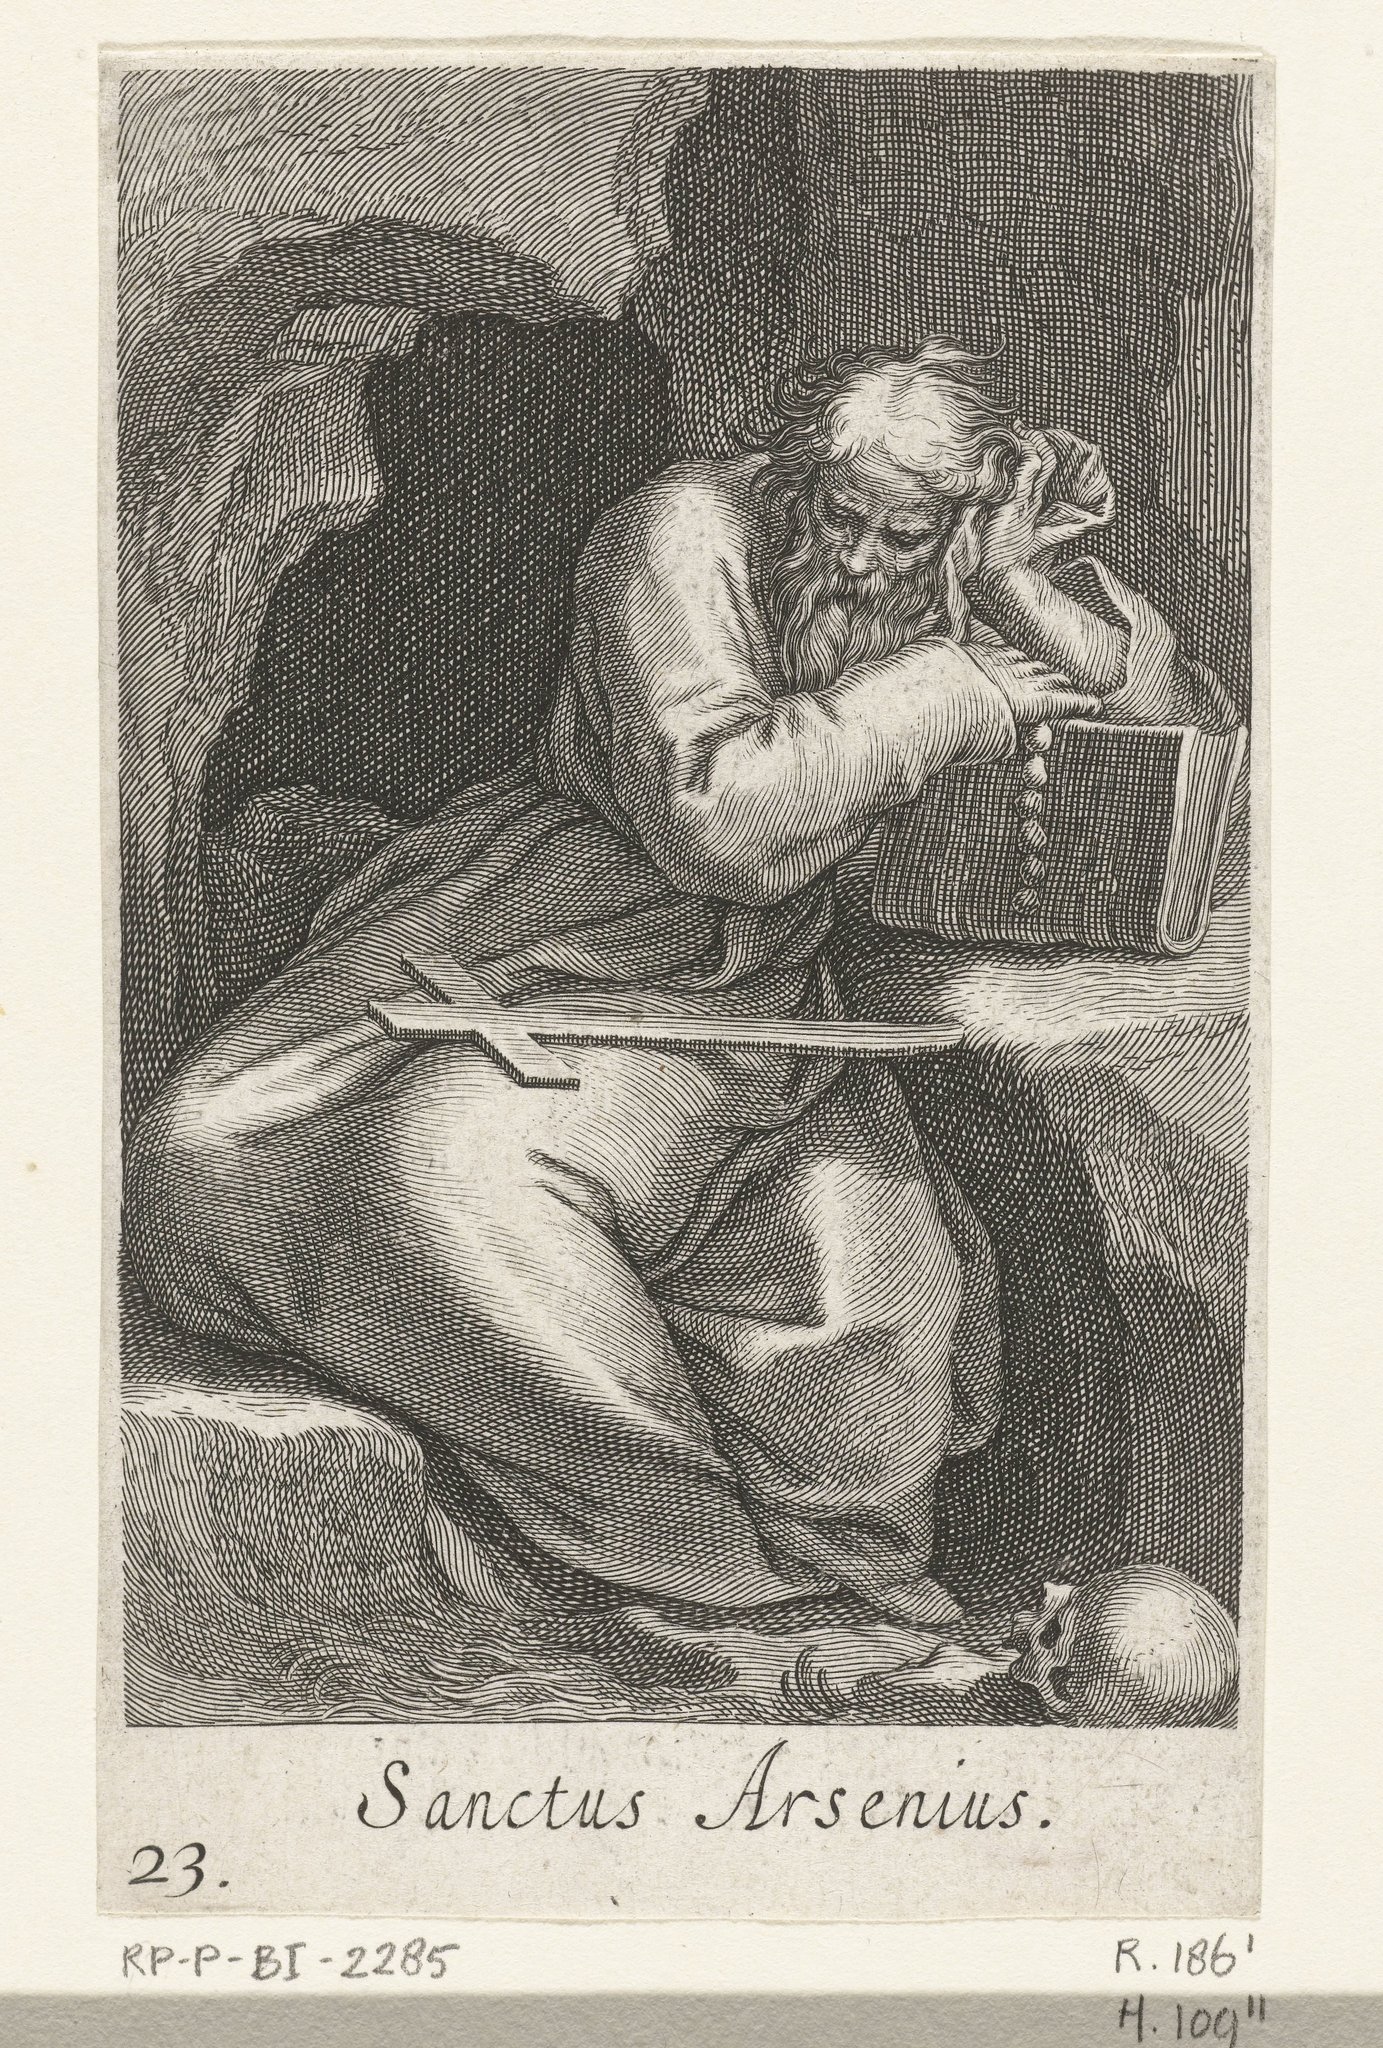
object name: book illustration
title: Sacra eremvs ascetarvm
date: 1590-1612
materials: paper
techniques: engraving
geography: low countries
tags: saints, anchorite, hermit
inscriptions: collector's mark: Lugt 240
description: Prent uit: Sacra eremus ascetarum, Antwerpen, Hendrick Aertssen, 1619. Eerste gebonden uitgave met in totaal vijftig prenten. Prent uit serie van vijfentwintig mannelijke kluizenaars. In 1612 verscheen een ongebonden editie maar op basis van de gewijzigde opschriften en samenstelling wordt aangenomen dat de prenten van de uitgave 1619 ook in 1612 of iets daarvoor gedrukt werden. Roethlisberger beschouwt de uitgave van 1619 als de eerste staat en de ongebonden editie van 1612 als de tweede staat (Roethlisberger 1993, p. 171, 172).